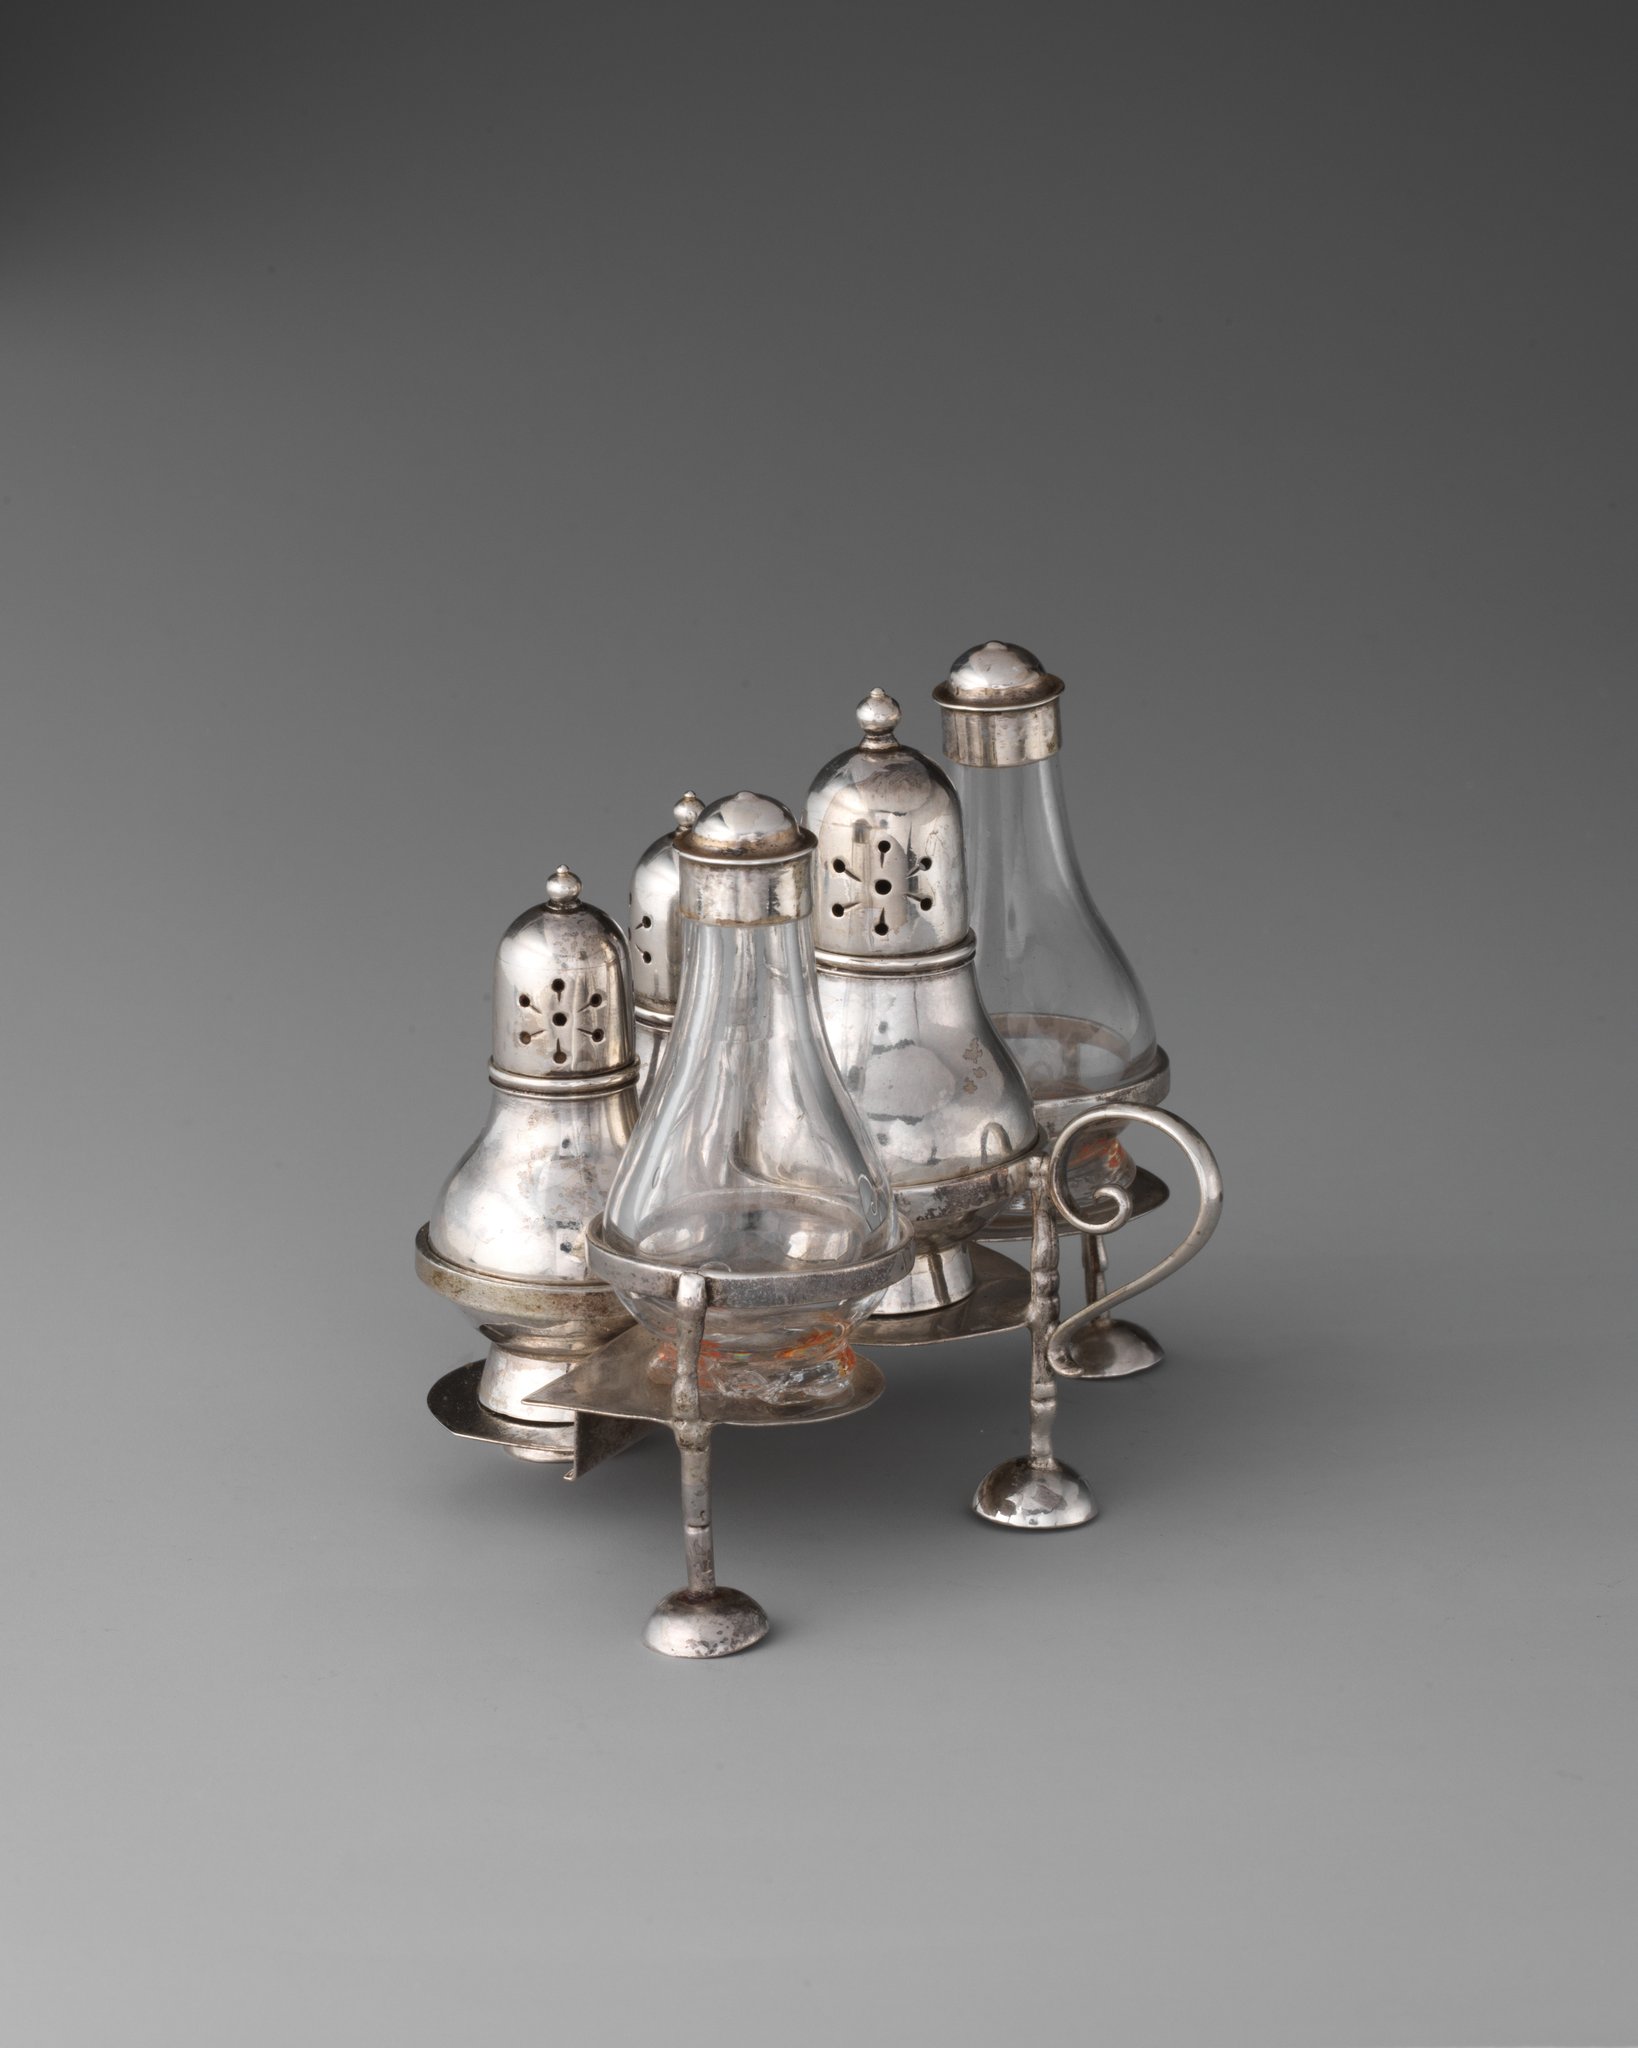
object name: cruet stand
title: Miniature cruet stand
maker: david clayton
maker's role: artist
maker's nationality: british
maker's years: 1659-1719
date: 1720-1723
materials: glass, silver